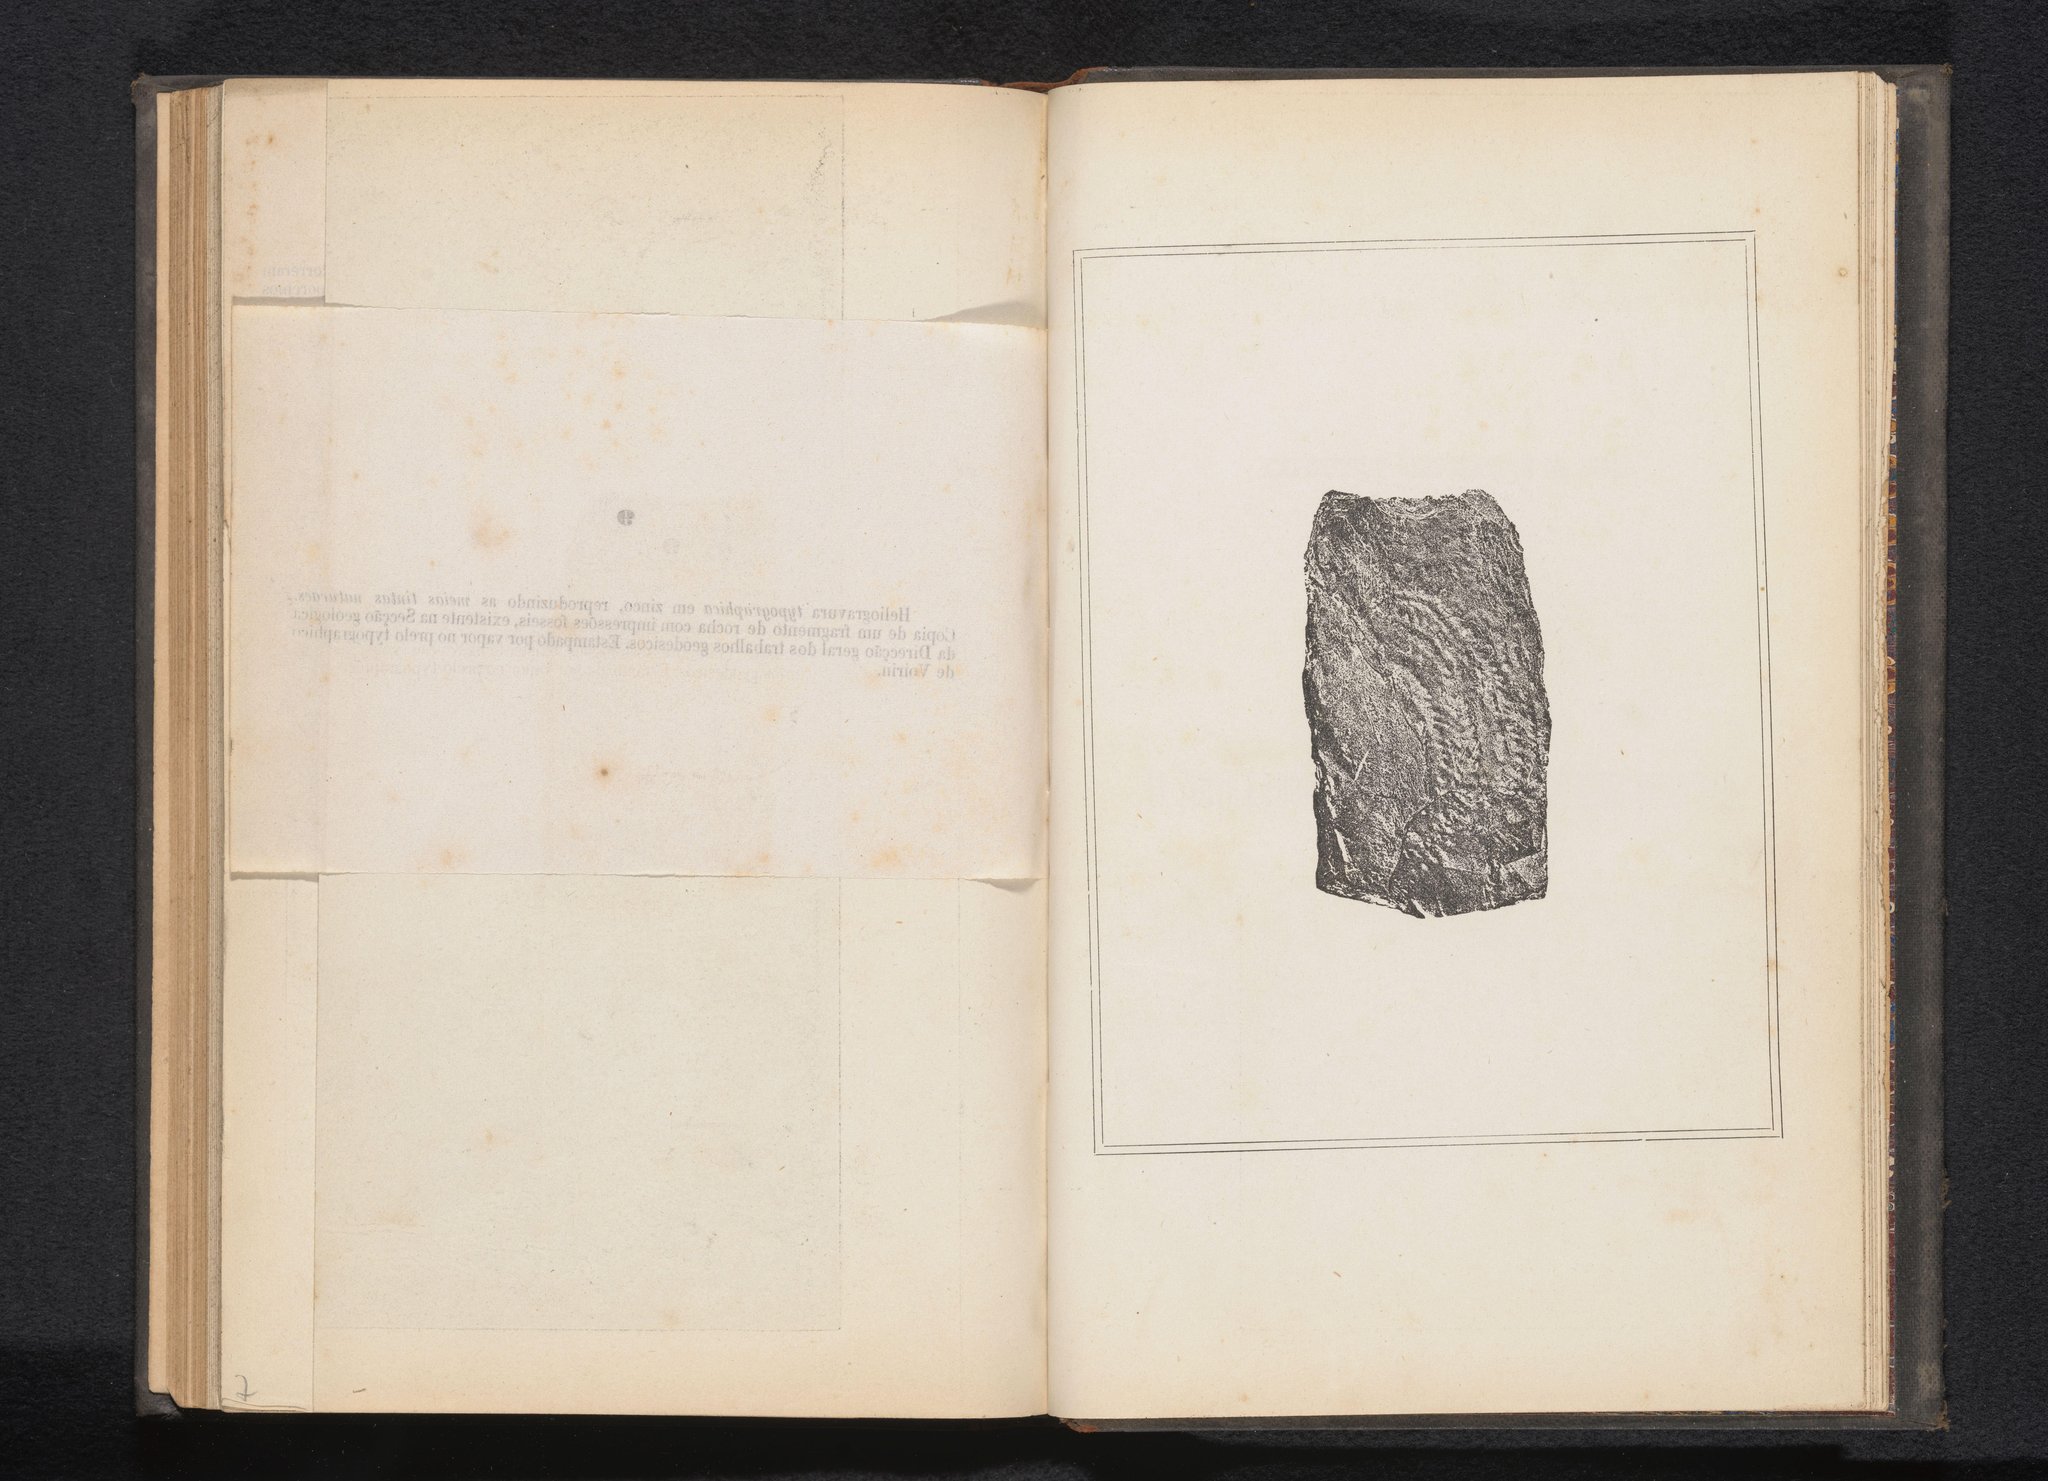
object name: page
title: Steen met een fossiel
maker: Anonymous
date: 1866-1876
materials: paper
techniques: photoaquatint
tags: fossil animals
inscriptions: number: ‘9’